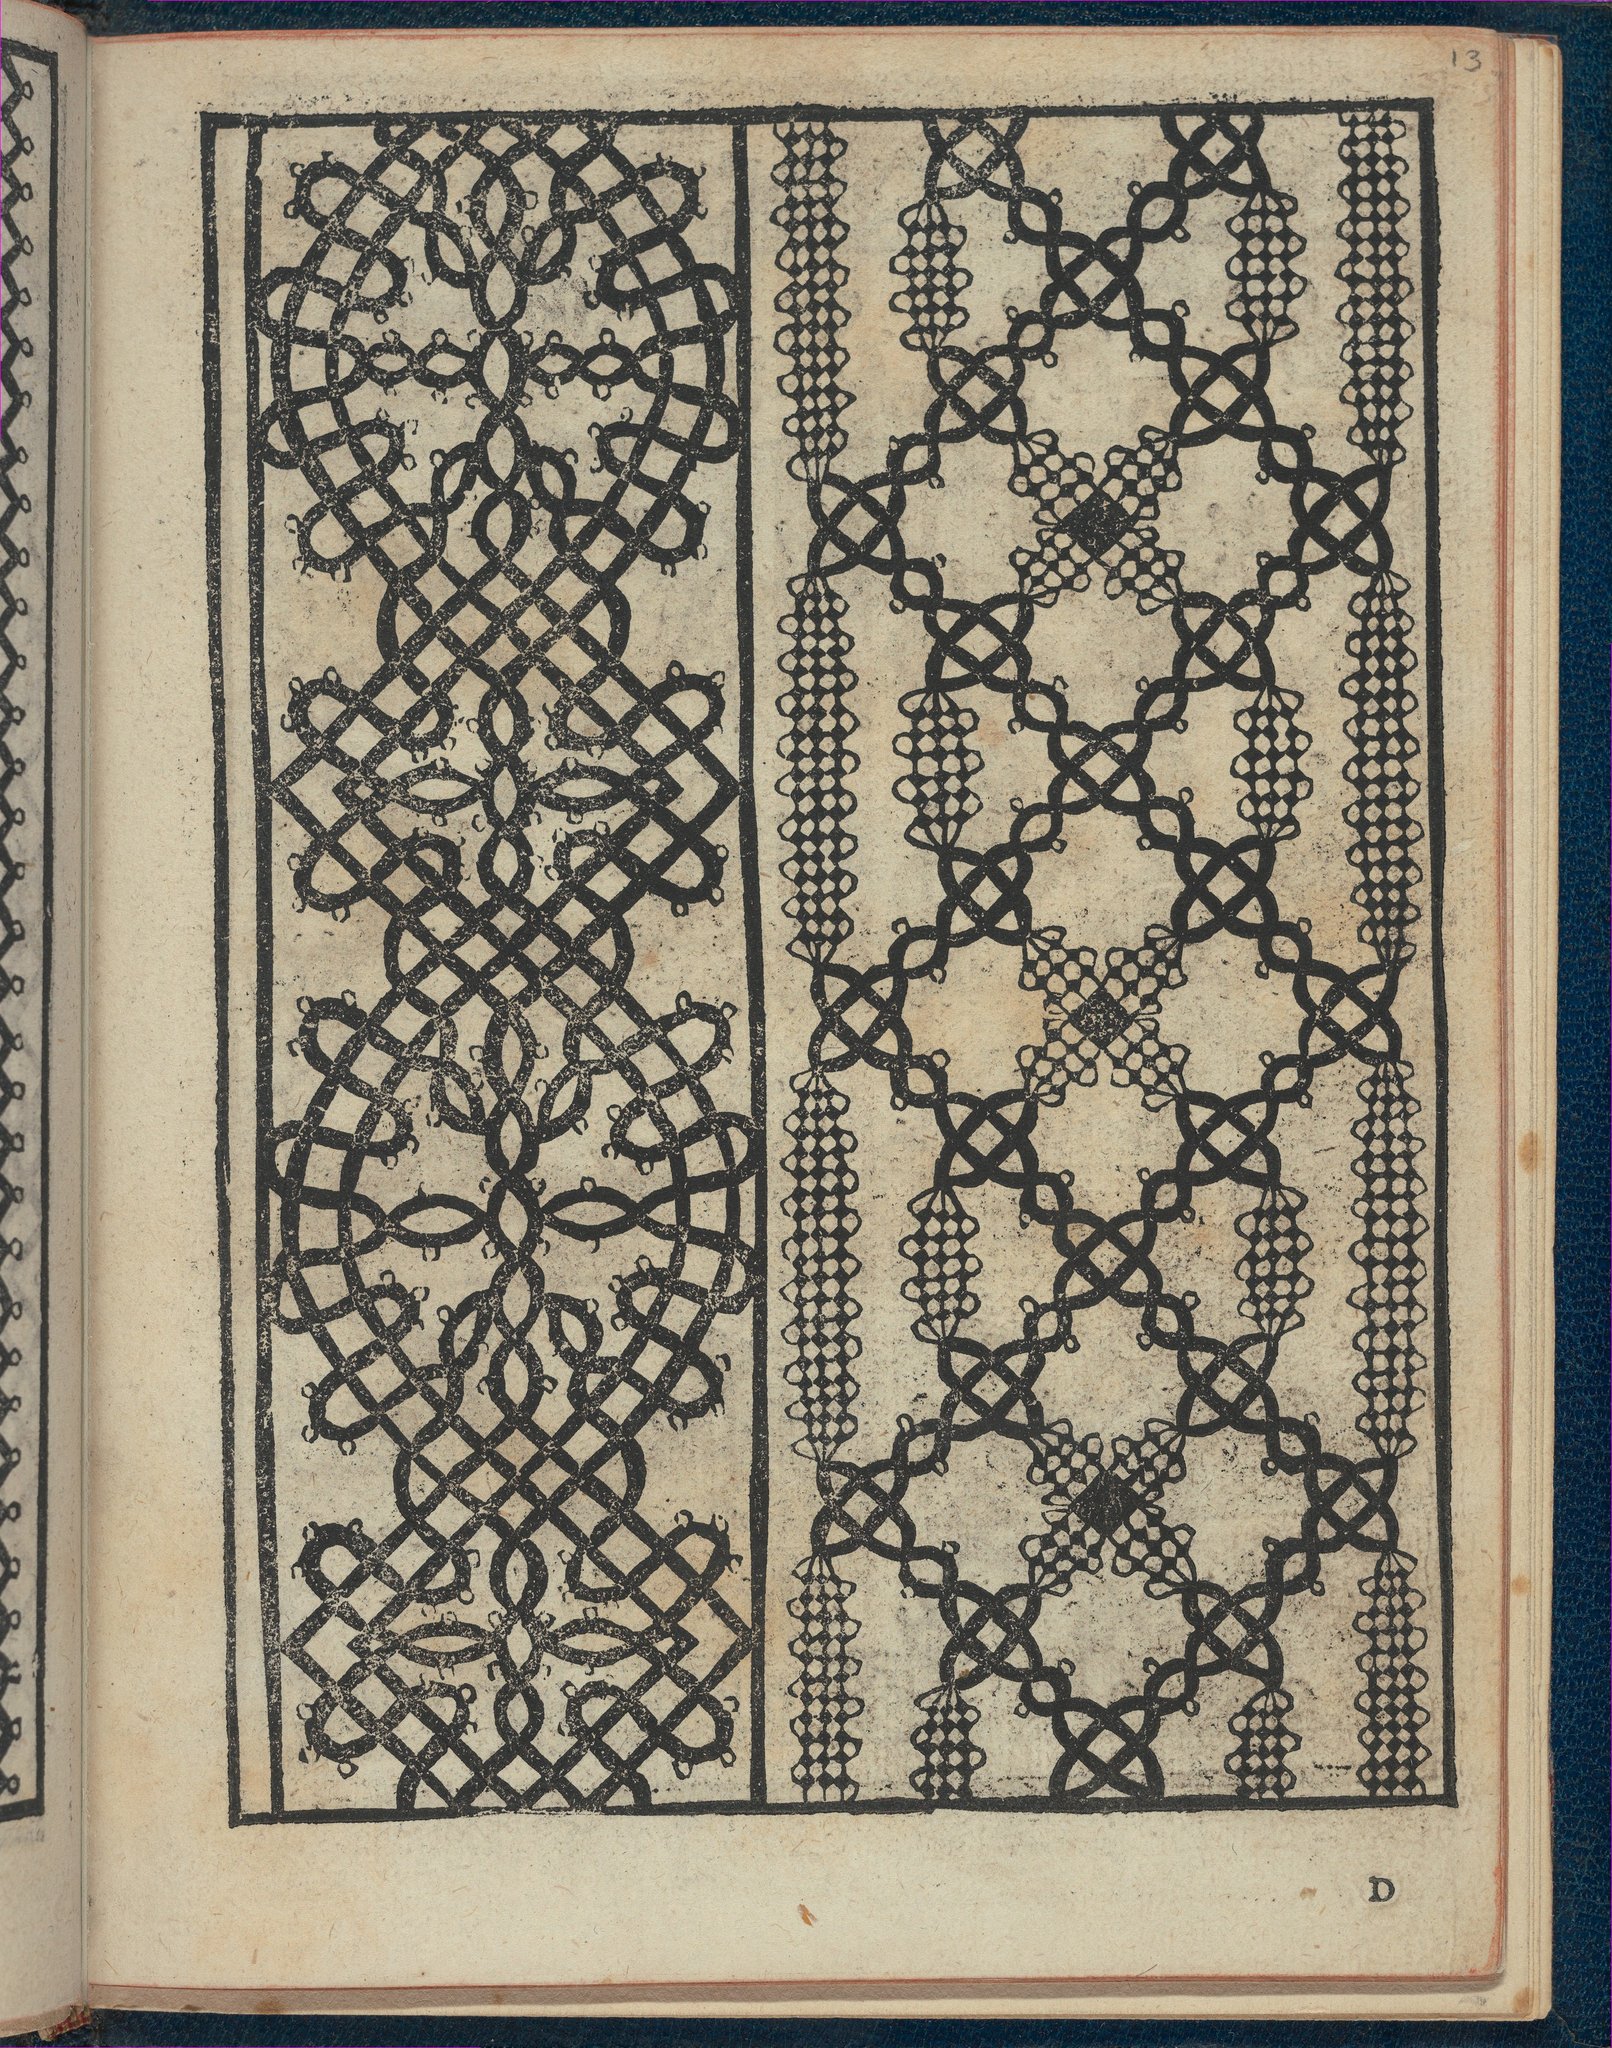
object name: book print ornament architecture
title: Le Pompe: Opera Nova, page 7 (recto)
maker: giovanni battista & marchio sessa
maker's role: publisher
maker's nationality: italian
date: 1557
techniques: woodcut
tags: ornament